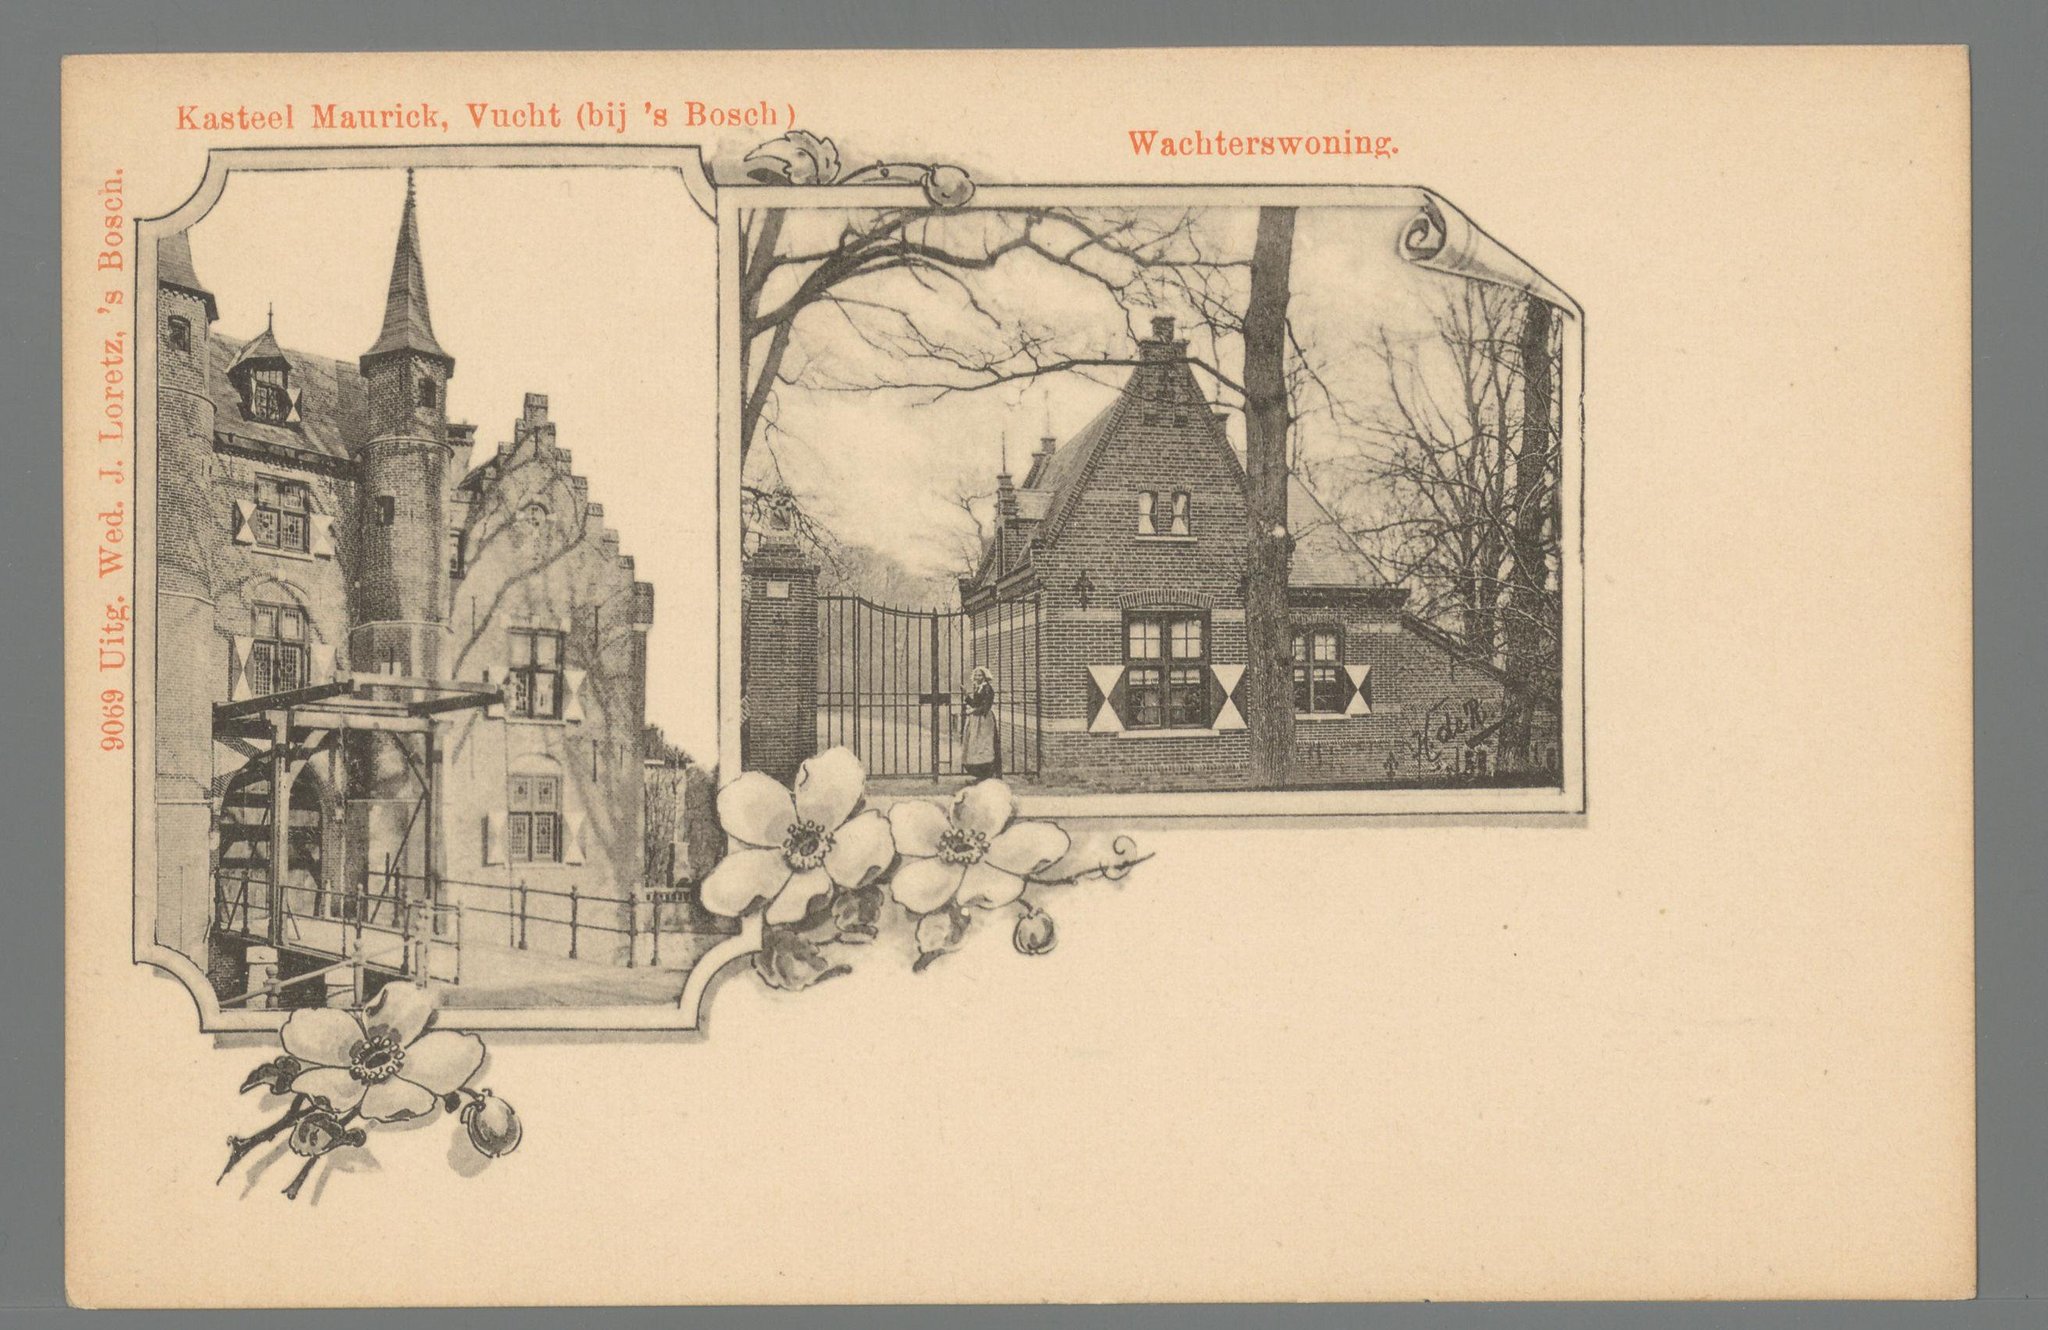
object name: photomechanical print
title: Kasteel Maurick, Vucht (bij 's Bosch). Wachterswoning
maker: Anonymous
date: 1892-1900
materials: cardboard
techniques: photograph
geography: vught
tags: castle, cottage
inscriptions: monogram: ‘HdeR’